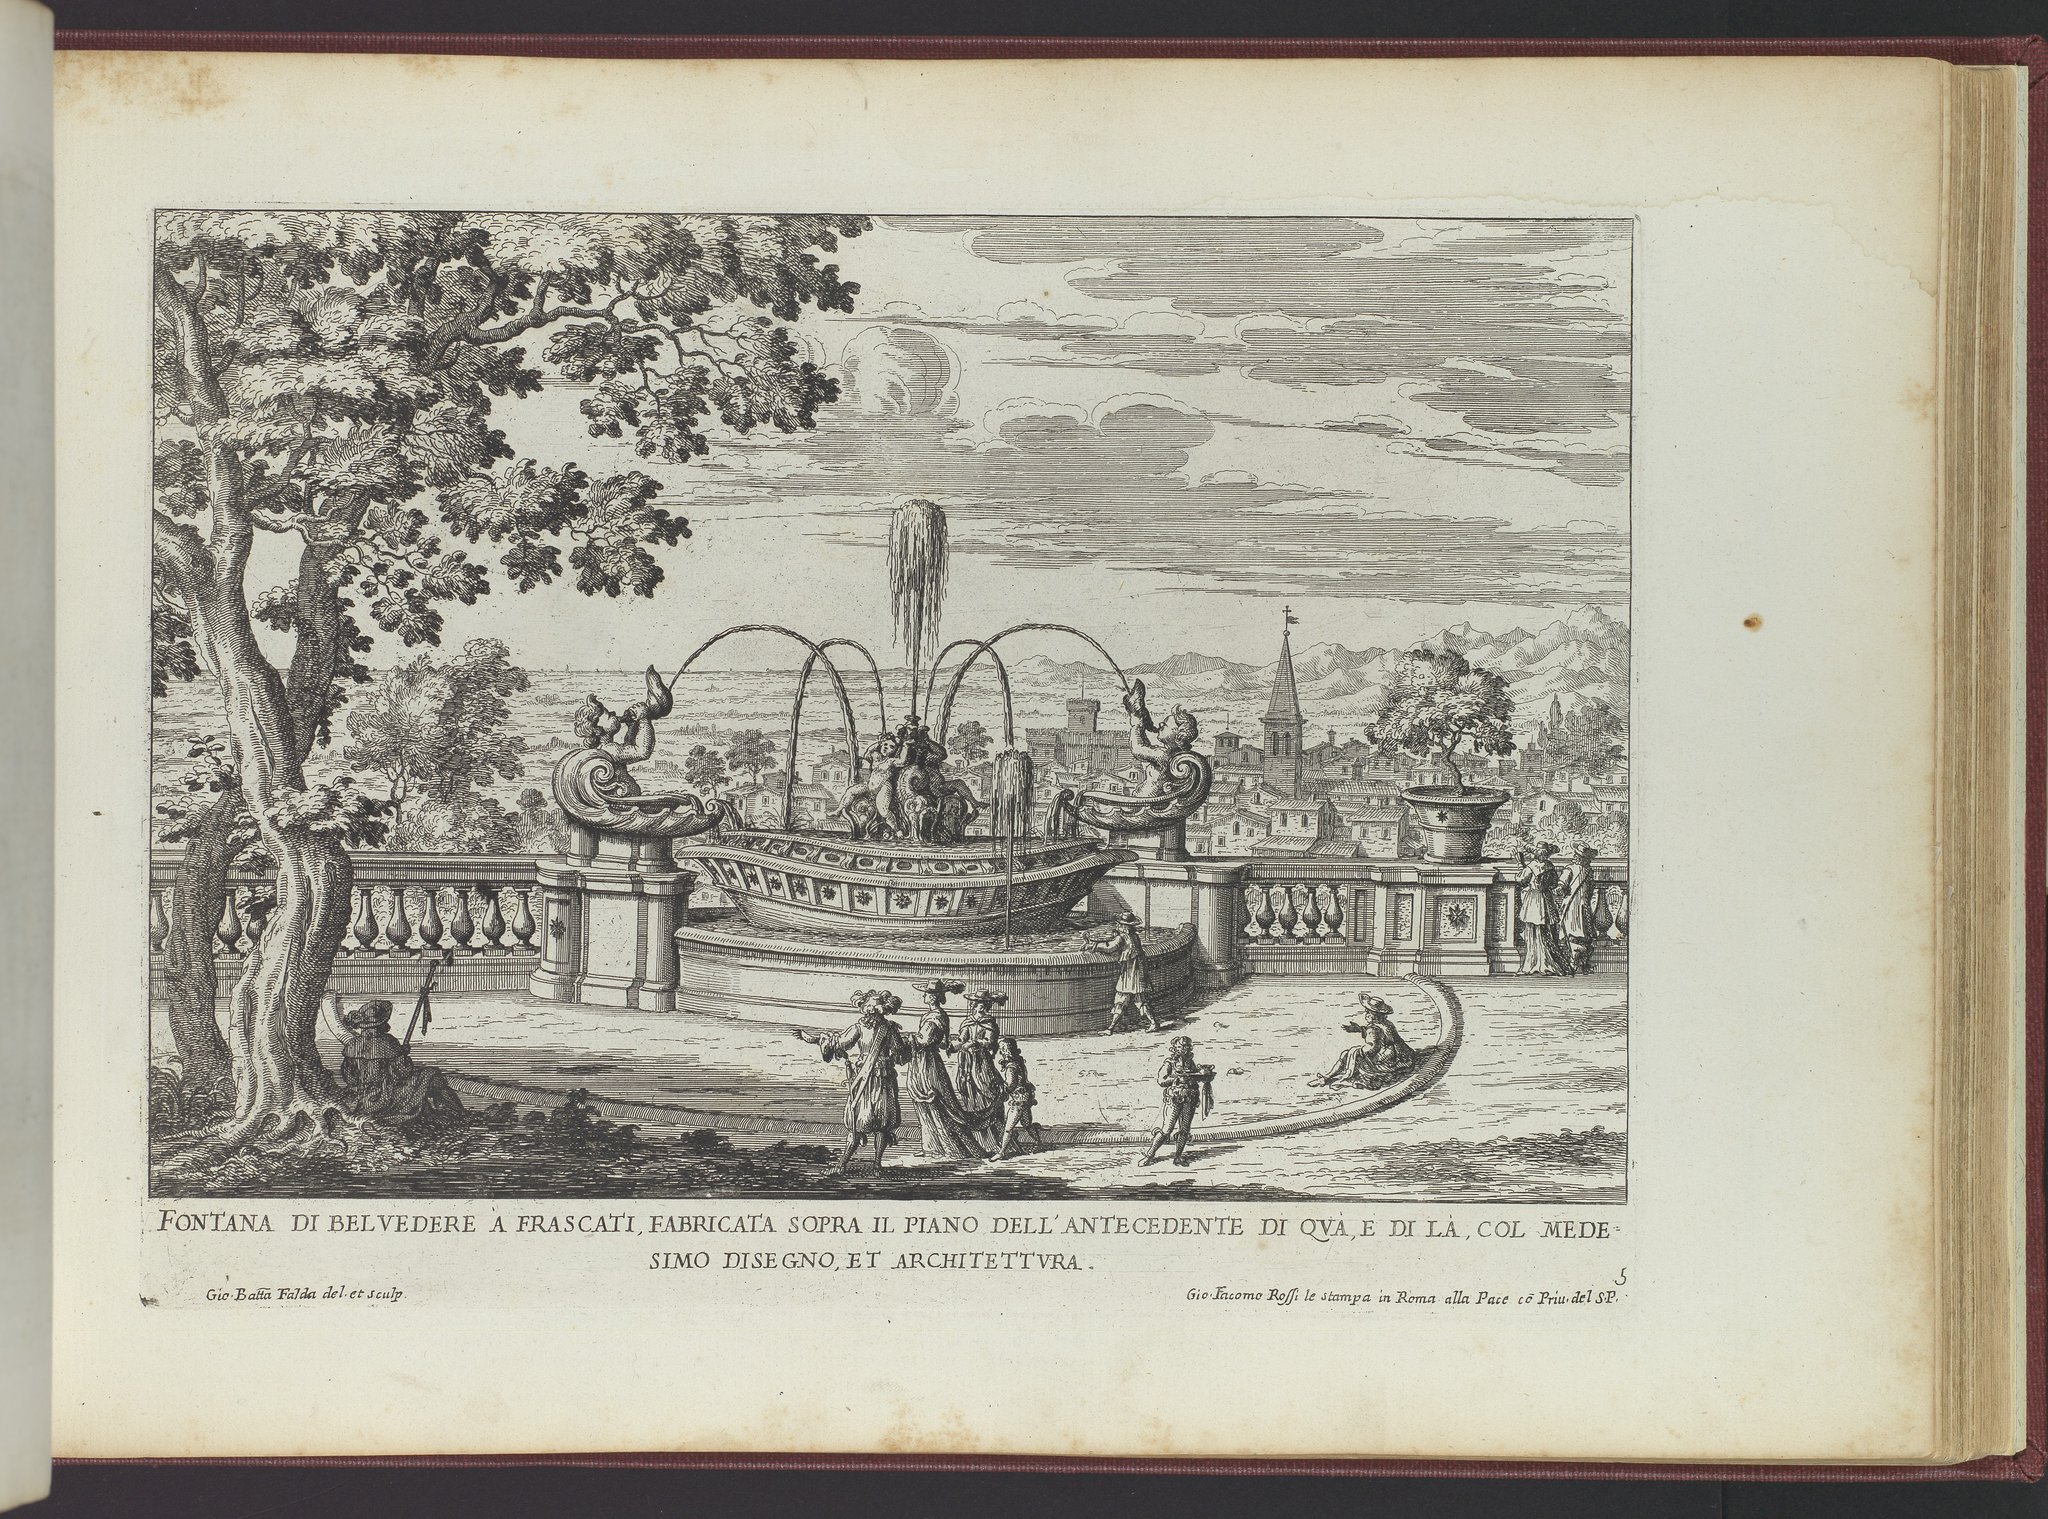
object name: collection ornament architecture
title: Fontana di Belvedere á Frascati (...), from 'La Fontane di Roma nelle Piazze e Luoghi Publici (...)', part 2, 'Le fontane delle ville di Frascati' (plate 5)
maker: giovanni battista falda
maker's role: artist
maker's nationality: italian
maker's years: 1643-1678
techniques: etching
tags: fountains,men,women